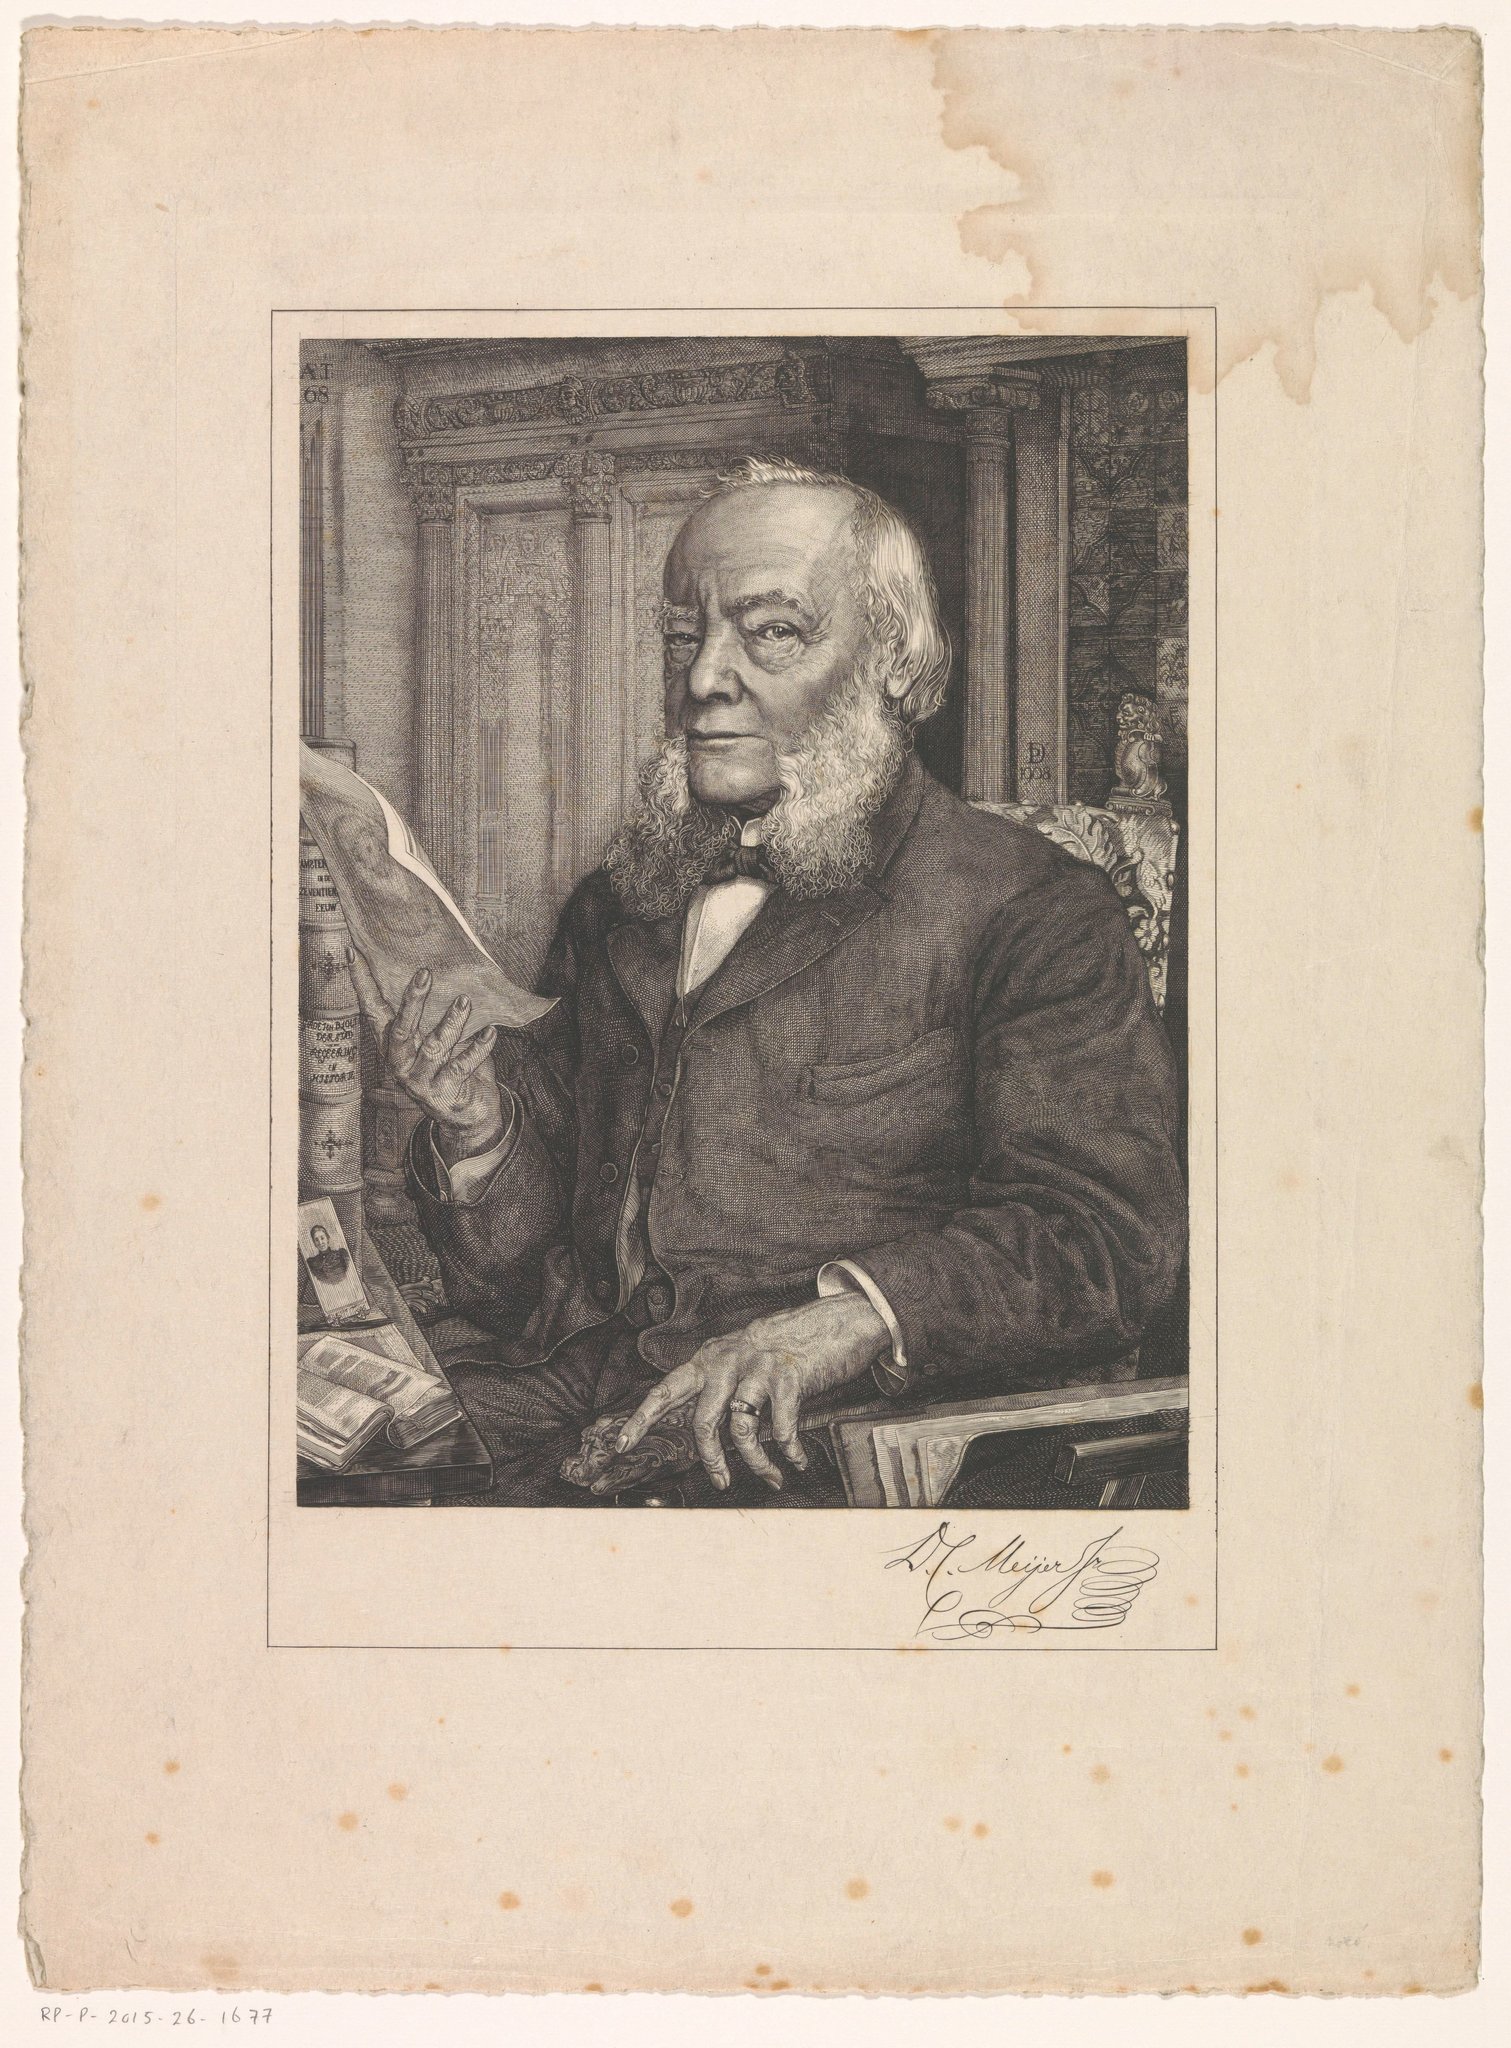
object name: print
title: Portret van Dirk Christiaan Meijer jr.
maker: pieter dupont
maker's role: draughtsman, print maker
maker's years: 1870-1911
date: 1908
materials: paper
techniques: engraving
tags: dirk christiaan meijer jr., print, e.g.: engraving, etching, lithograph, historical persons, art collector, book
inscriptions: collector's mark: Lugt 4779, collector's mark: Lugt 2228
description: Portret van de oudheidkundige, wijnhandelaar en antiekverzamelaar Dirk Christiaan Meijer jr., tevens mede-oprichter van het Genootschap Amstelodamum en penningmeester van het Koninklijk Oudheidkundige Genootschap. Meijer zit in een stoel met een prent in zijn rechterhand. Naast hem een map met prenten in een standaard. Op de tafel voor hem boeken en een foto in een lijst. In de achtergrond een kast en een schouw. Op deze vierde staat van de prent is de signatuur van Meijer toegevoegd.